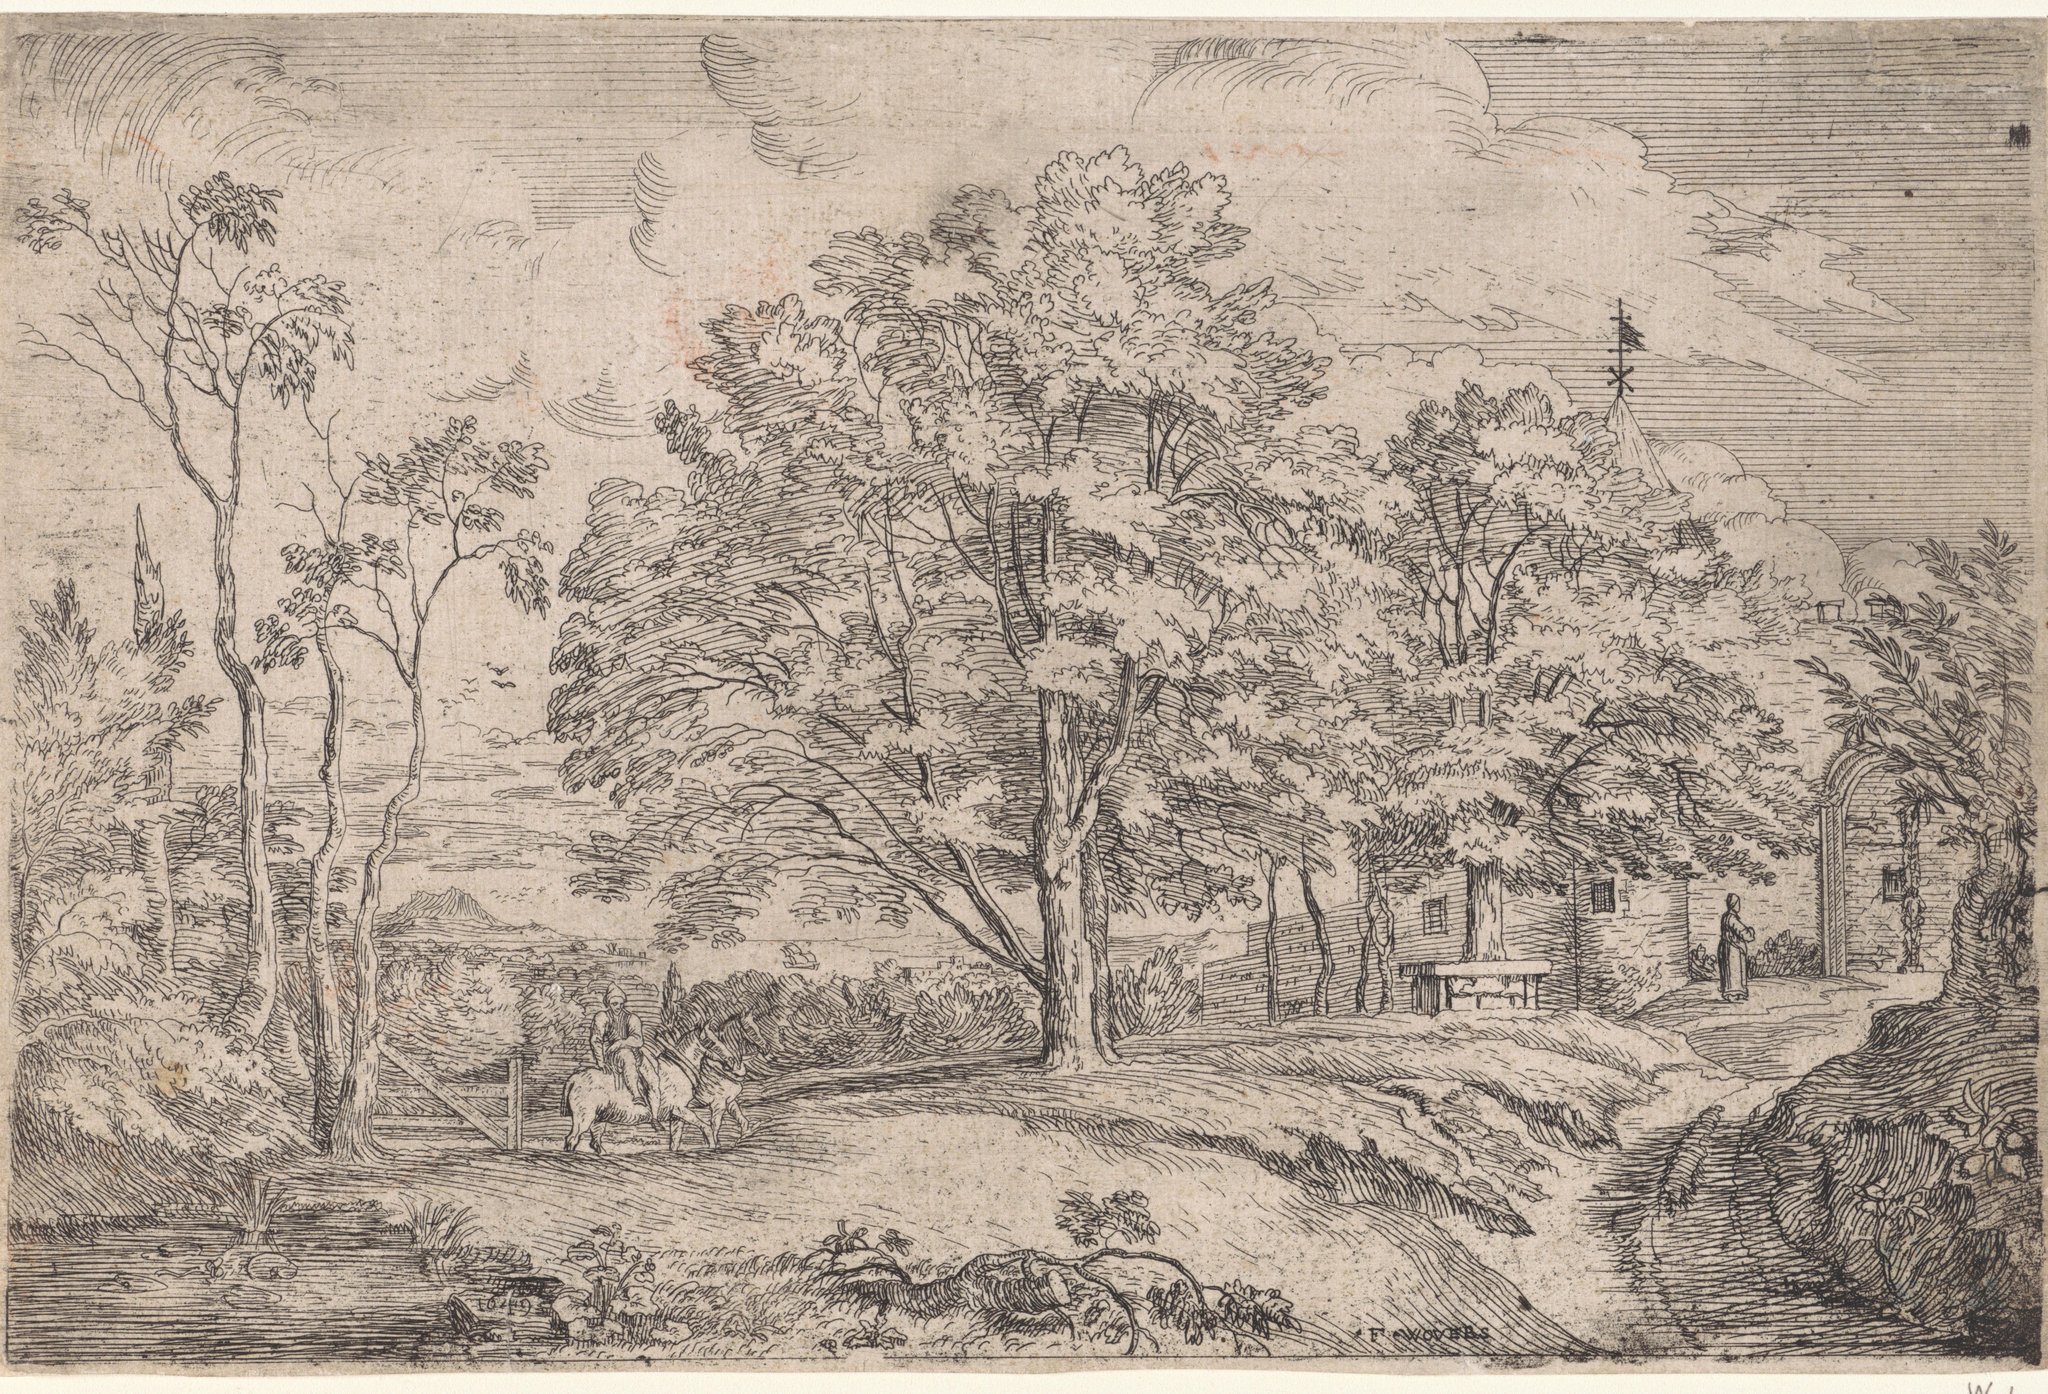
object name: print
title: Landschap met links een ruiter met twee paarden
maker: frans wouters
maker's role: draughtsman, painter, print maker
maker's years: 1612-1659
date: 1649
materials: paper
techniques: etching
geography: antwerp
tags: landscapes in the temperate zone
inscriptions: collector's mark: Lugt 514, collector's mark: Lugt 2165